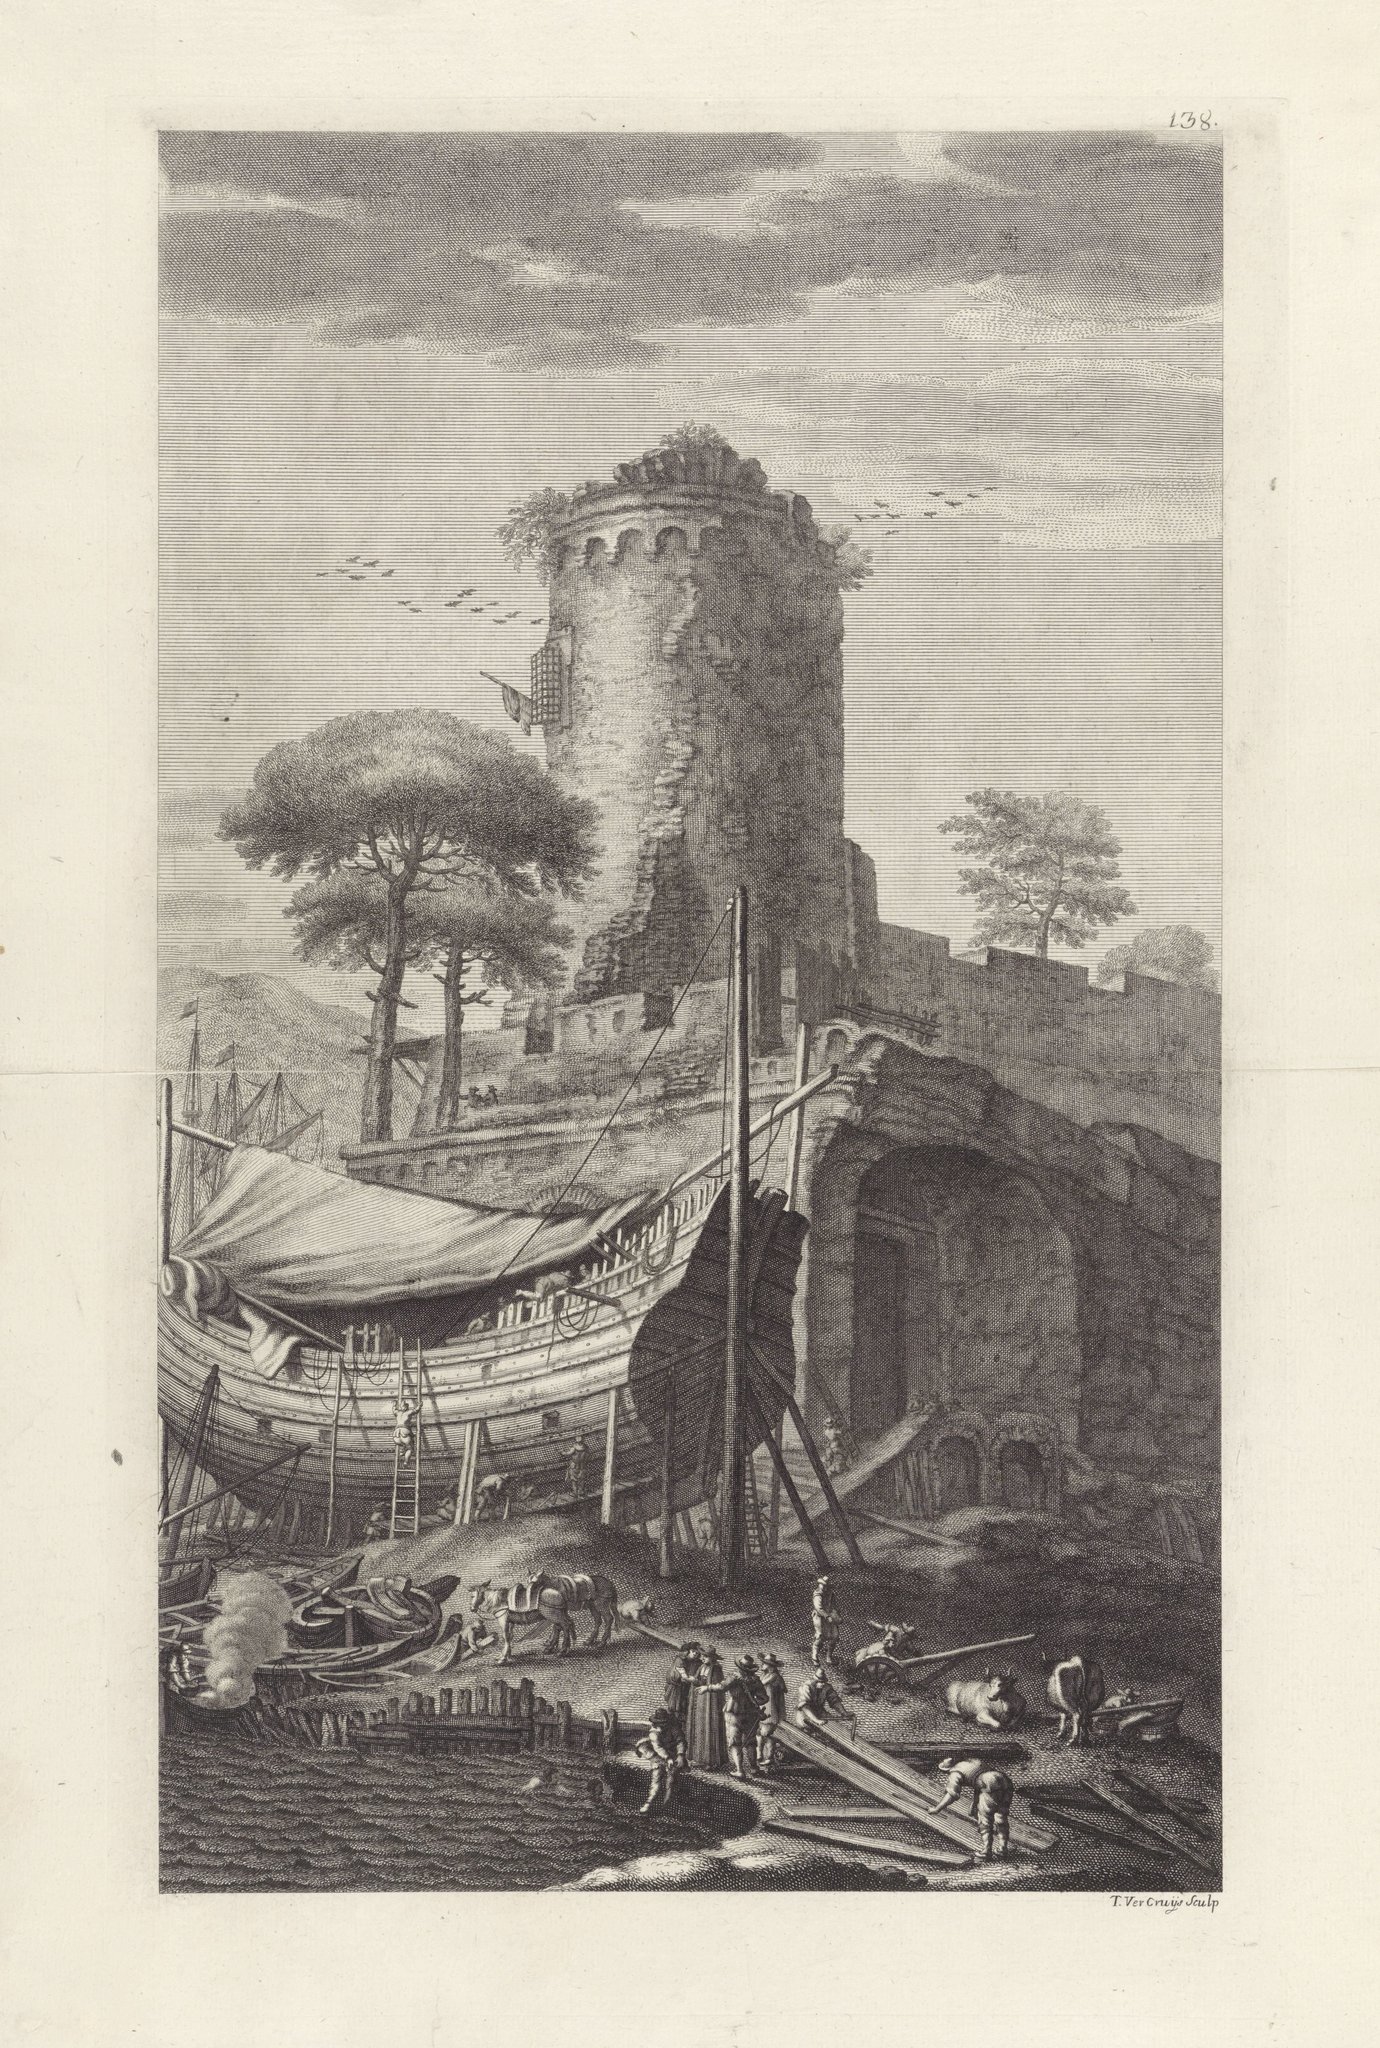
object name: print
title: Schip in steigers voor een toren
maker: theodor vercruys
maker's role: print maker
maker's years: 1680-1739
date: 1690-1739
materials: paper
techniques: engraving, etching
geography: italy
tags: towers ~ fortified city, building a ship, ship under construction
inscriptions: collector's mark: 2228, signature: ‘T.Ver Cruys Sculp.’ Lugt, number: ‘138’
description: Voor een stadswal of havenmuur met een toren ligt een schip in de steigers. Op de voorgrond zijn timmerlieden aan het werk. Rechtsboven: 138.